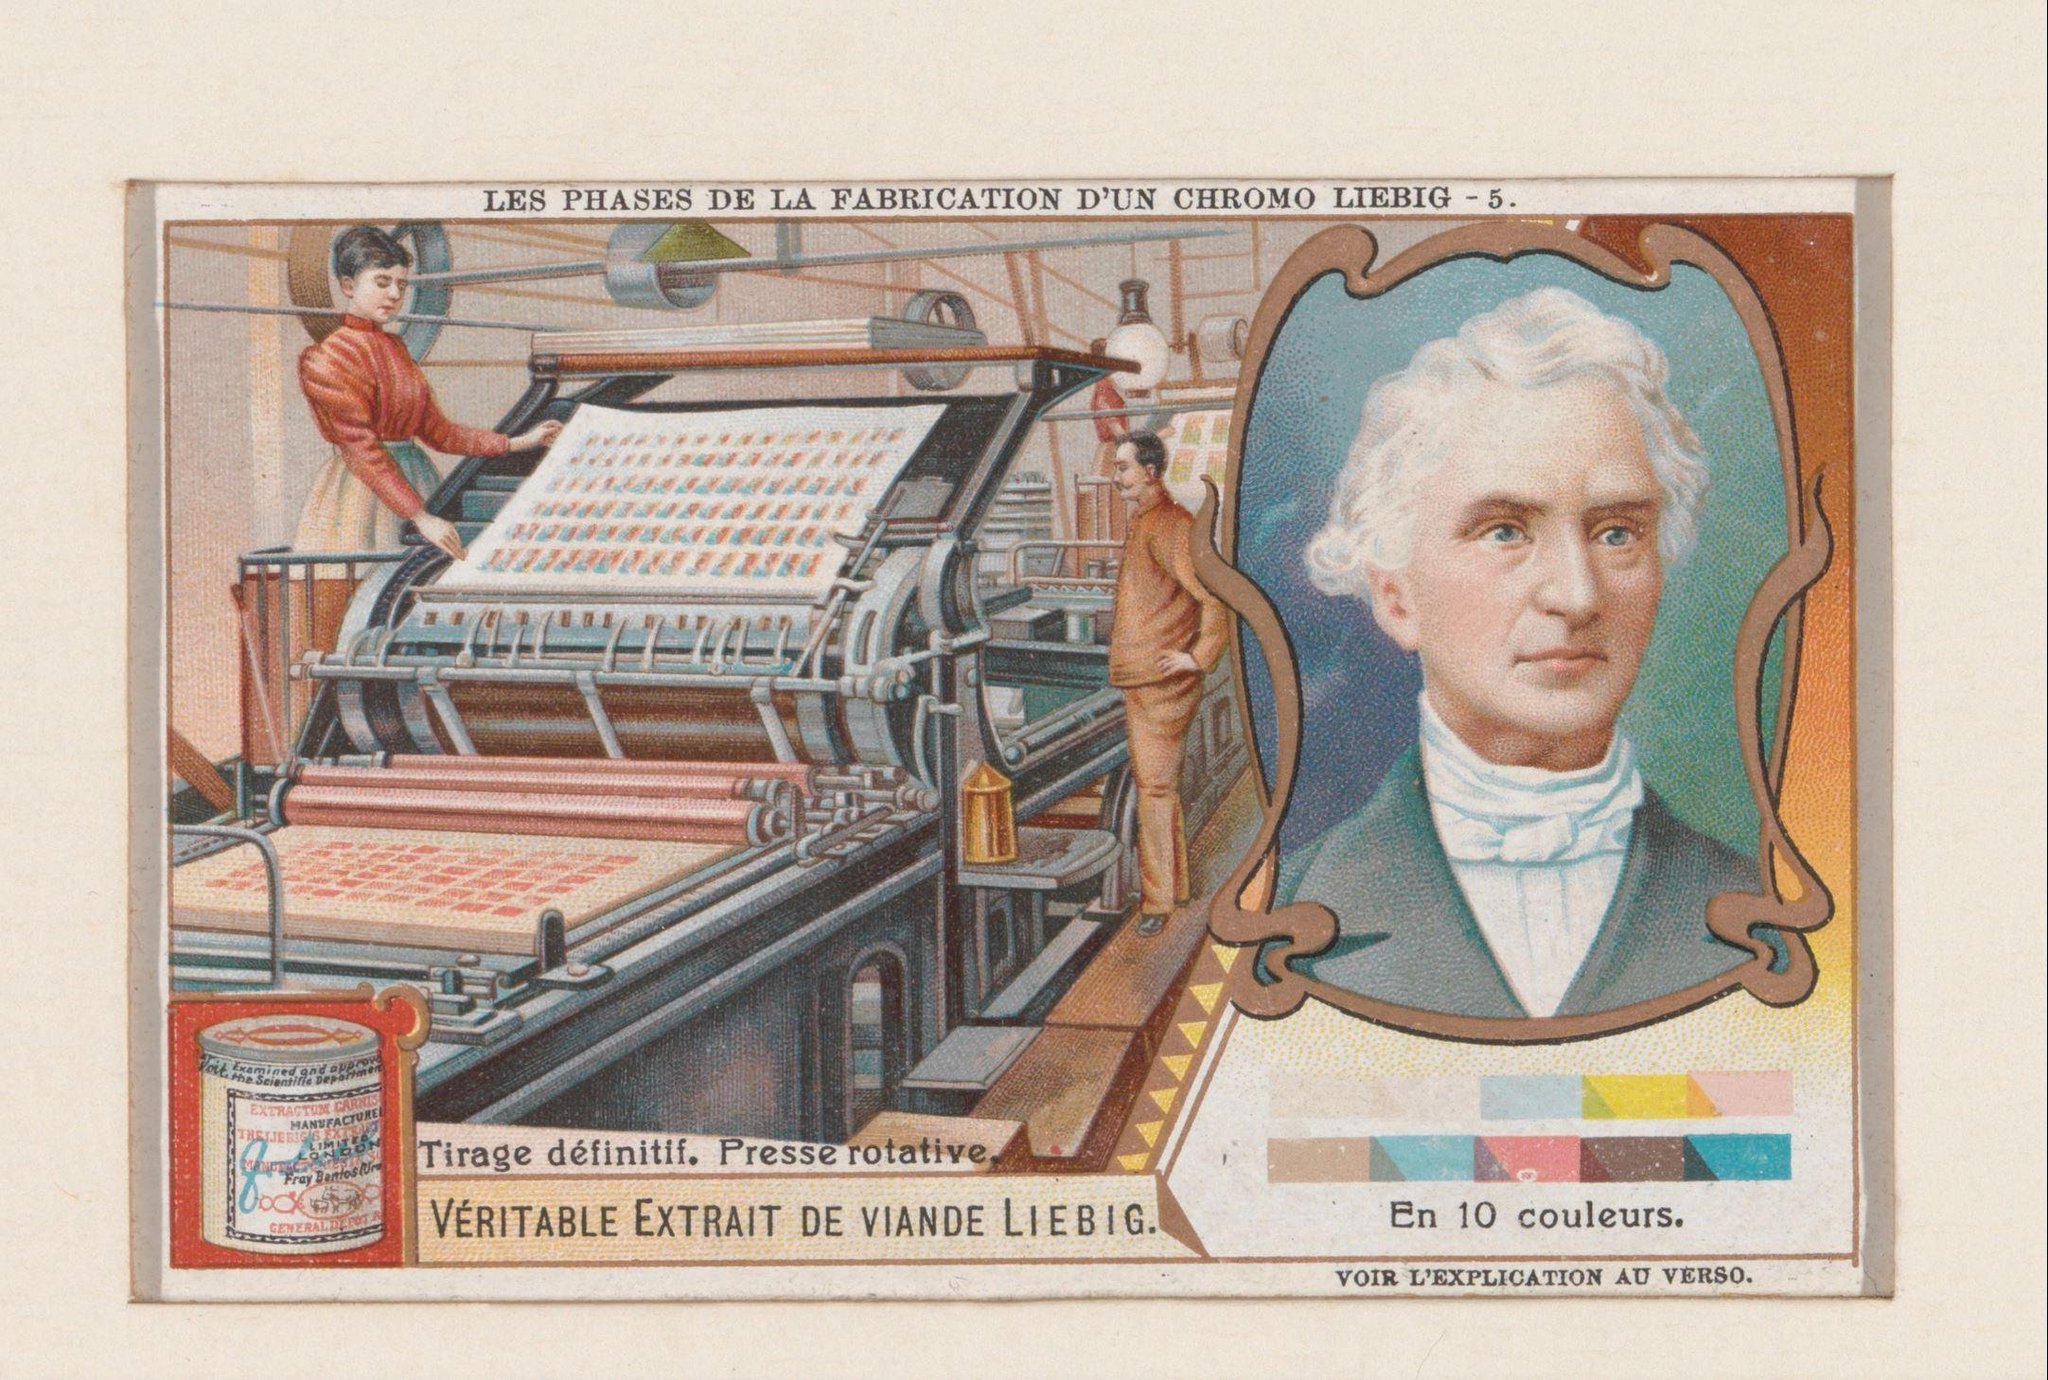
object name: print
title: Tirage définitf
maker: Anonymous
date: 1906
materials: paper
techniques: chromolithography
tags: historical persons, printing press, tools, implements of graphic artist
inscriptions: title: ‘Tirage définitf’, title: ‘VÉRITABLE EXTRAIT DE VIANDE LIEBIG.’